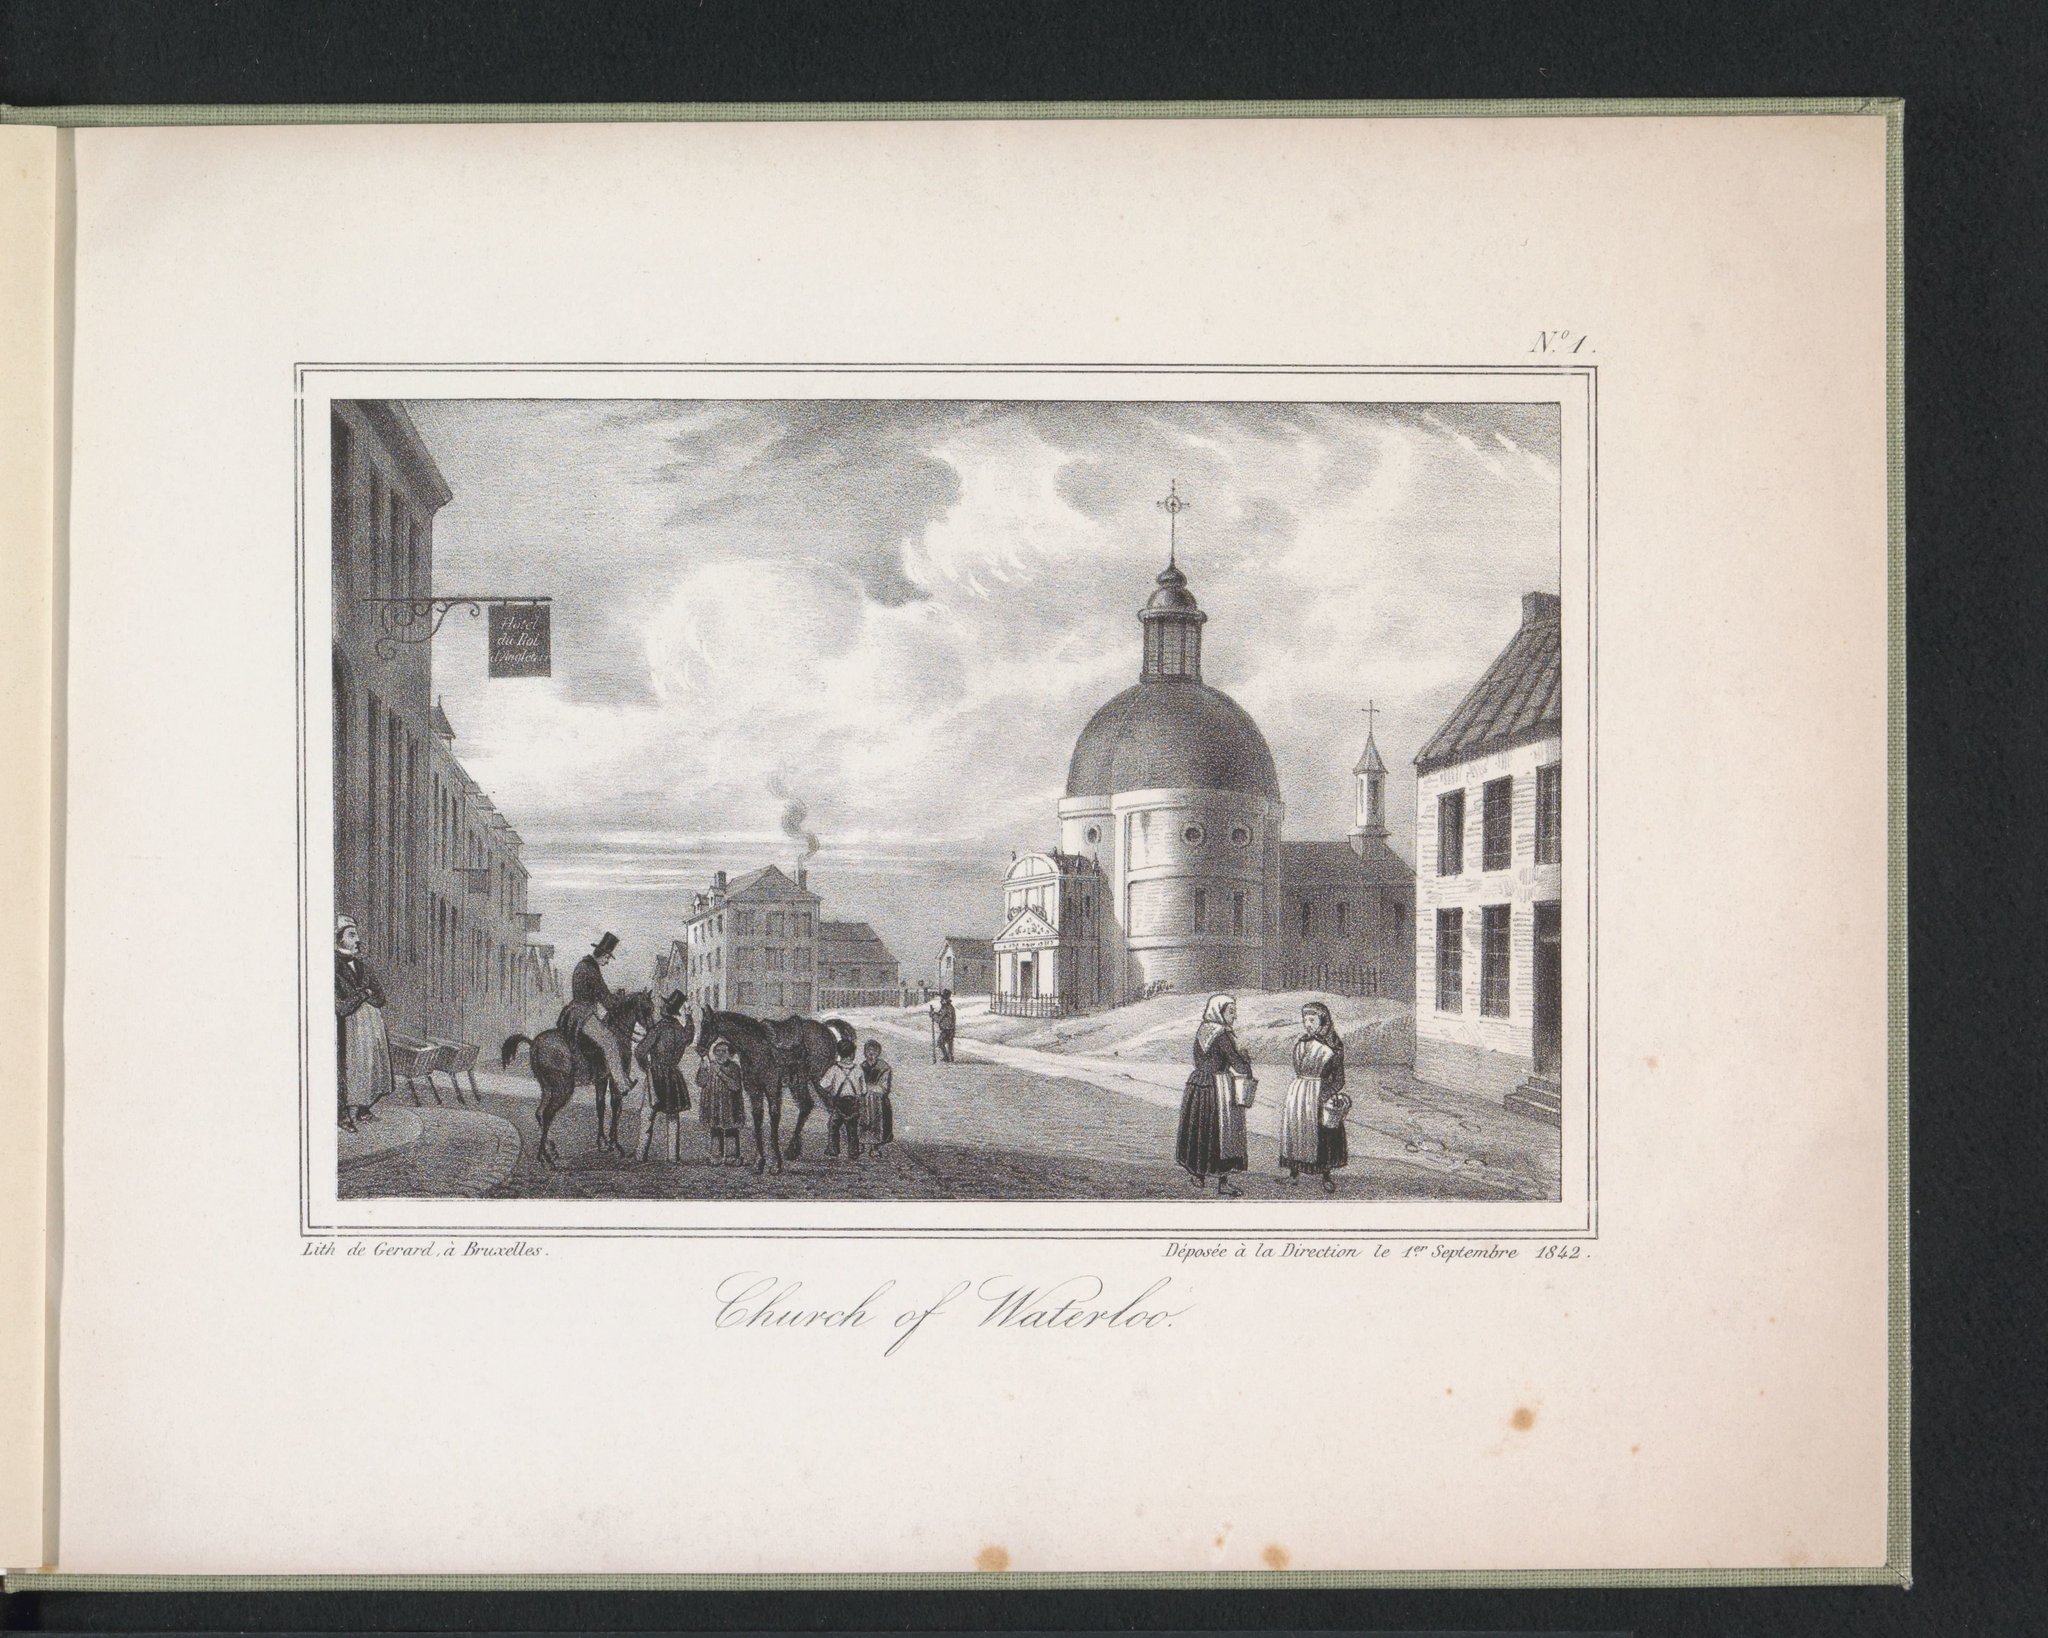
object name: print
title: Church of Waterloo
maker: h. gérard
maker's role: printer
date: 1842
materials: paper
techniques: lithograph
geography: brussels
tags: waterloo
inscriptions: date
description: Dit album bevat platen die 1842 zijn gedateerd en een kaart die 1846 is gedateerd. Het album is in verschillende edities met verschillende platen verschenen. Zie Atlas van Stolk, dl. VIII, p. 159-163, nr. 6436 voor beschrijvingen van drie van deze uitgaven.